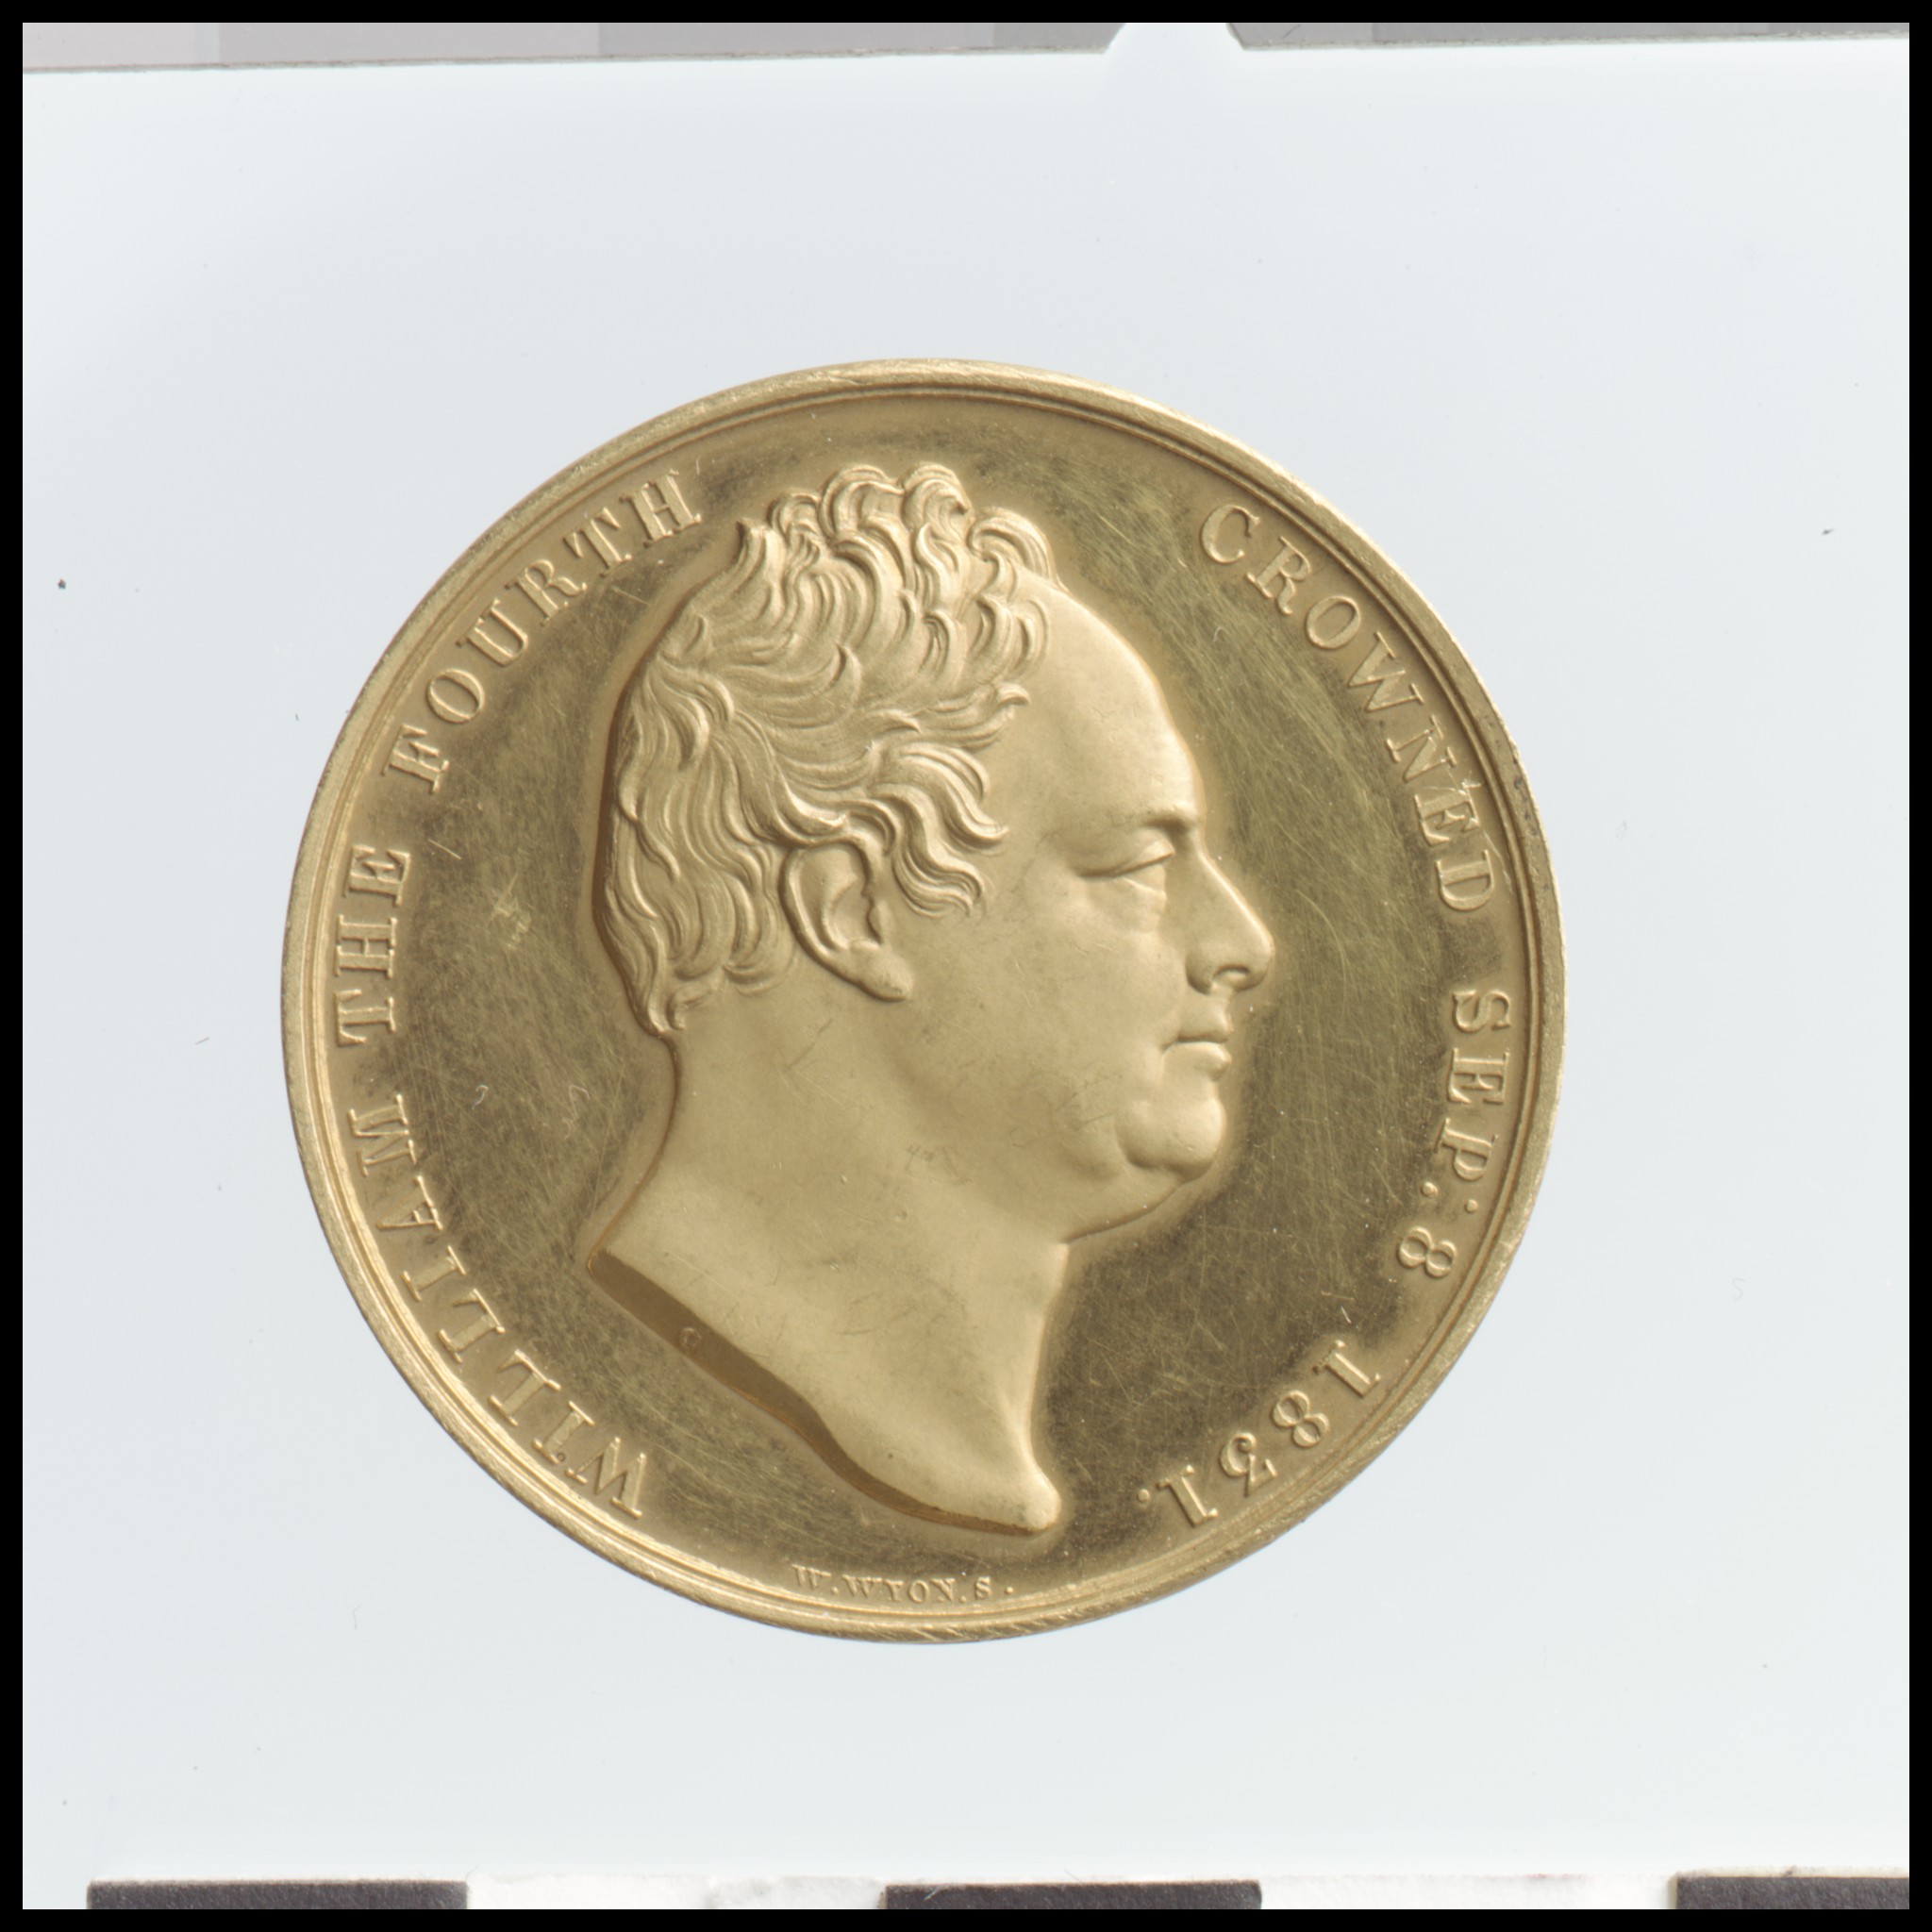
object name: medal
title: Coronation of William IV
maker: william wyon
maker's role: artist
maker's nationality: british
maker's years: 1795-1851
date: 1831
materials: gold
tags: kings,profiles